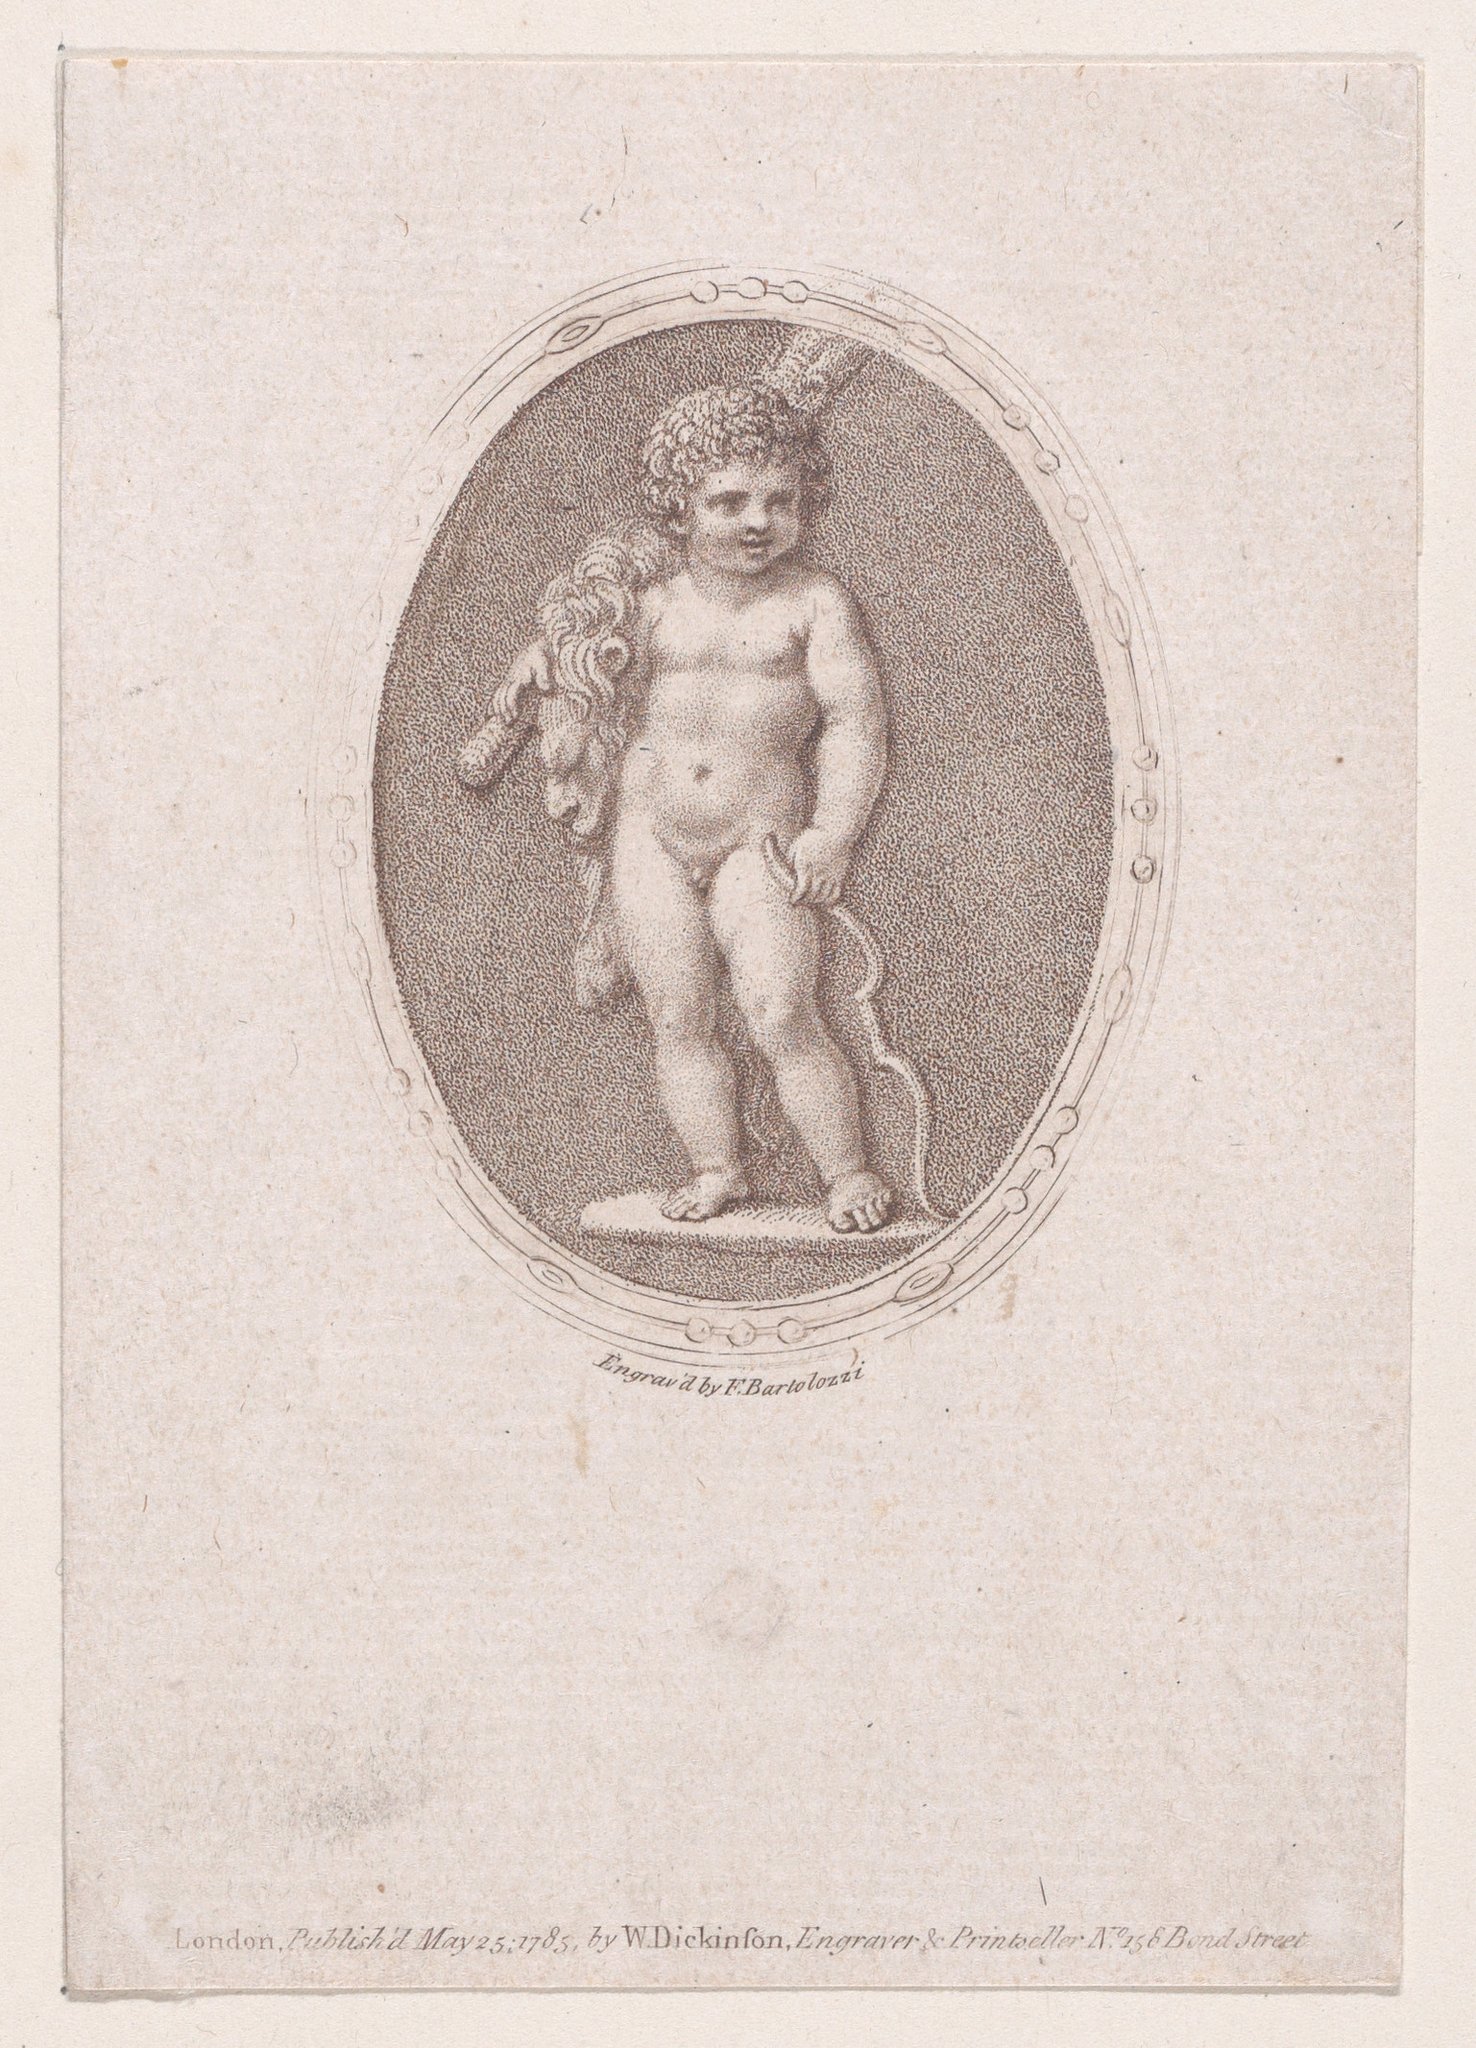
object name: print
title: Infant Hercules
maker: francesco bartolozzi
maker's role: artist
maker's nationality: italian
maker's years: 1728-1815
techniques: engraving, etching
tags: infants,hercules